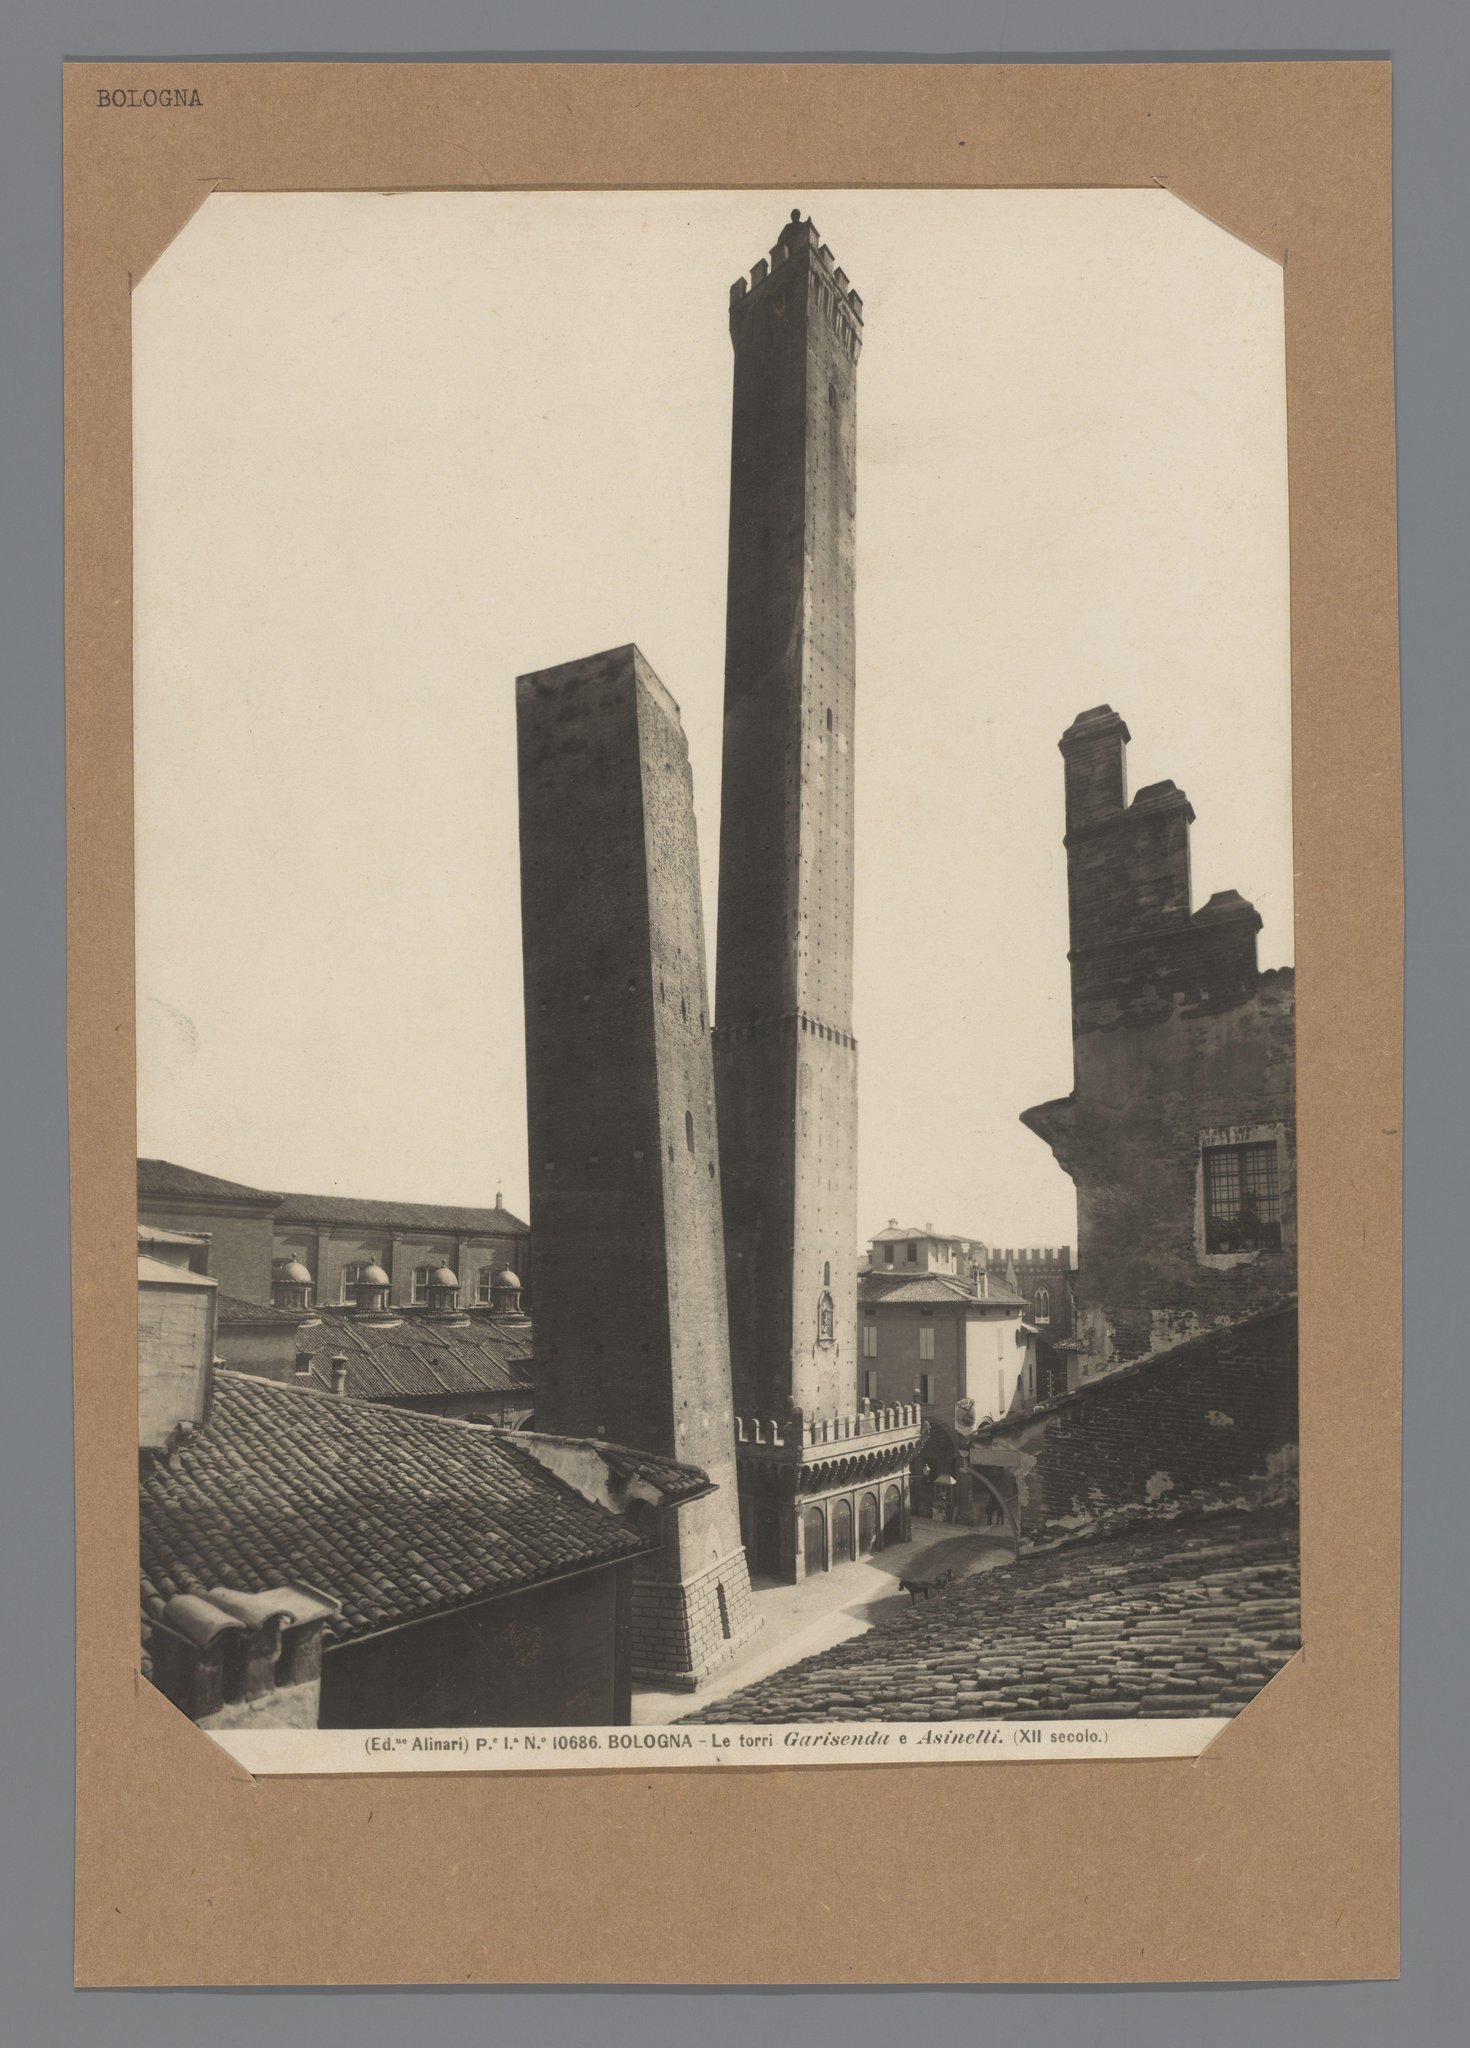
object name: photograph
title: Italië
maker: Anonymous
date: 1880-1910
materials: photographic support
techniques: albumen print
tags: italy